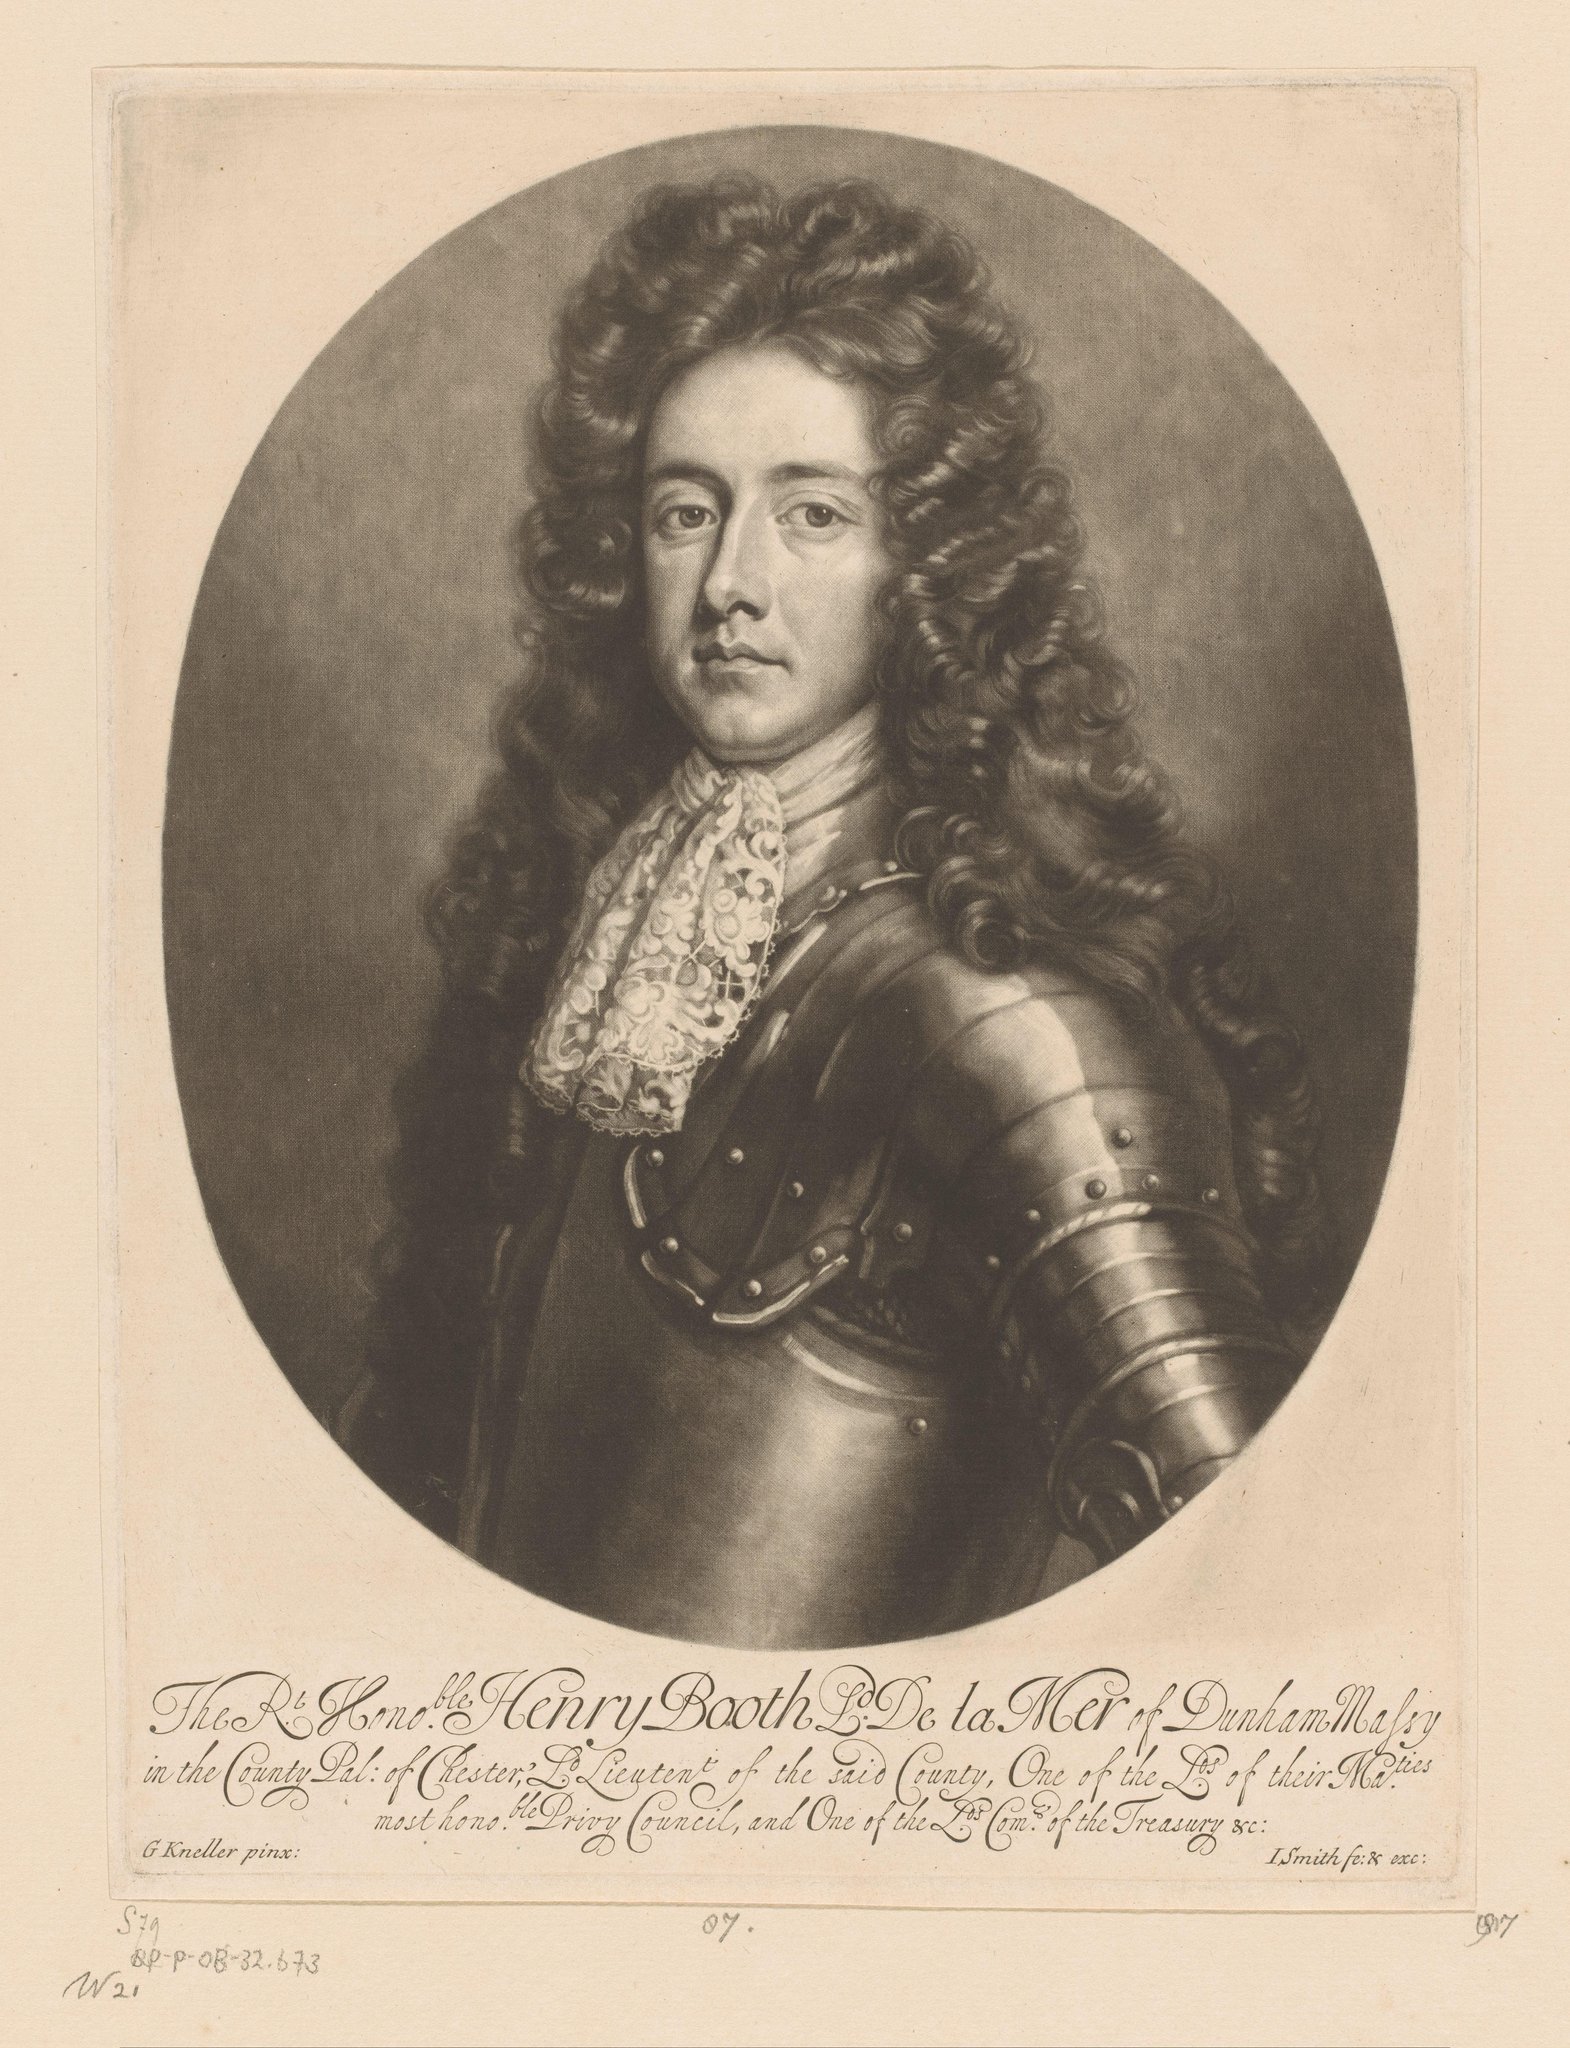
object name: print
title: Henry Booth De La Mer of Dunham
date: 1662-1742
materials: paper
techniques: mezzotint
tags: politician, historical persons, politician, e.g. party leader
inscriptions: collector's mark: Lugt 240